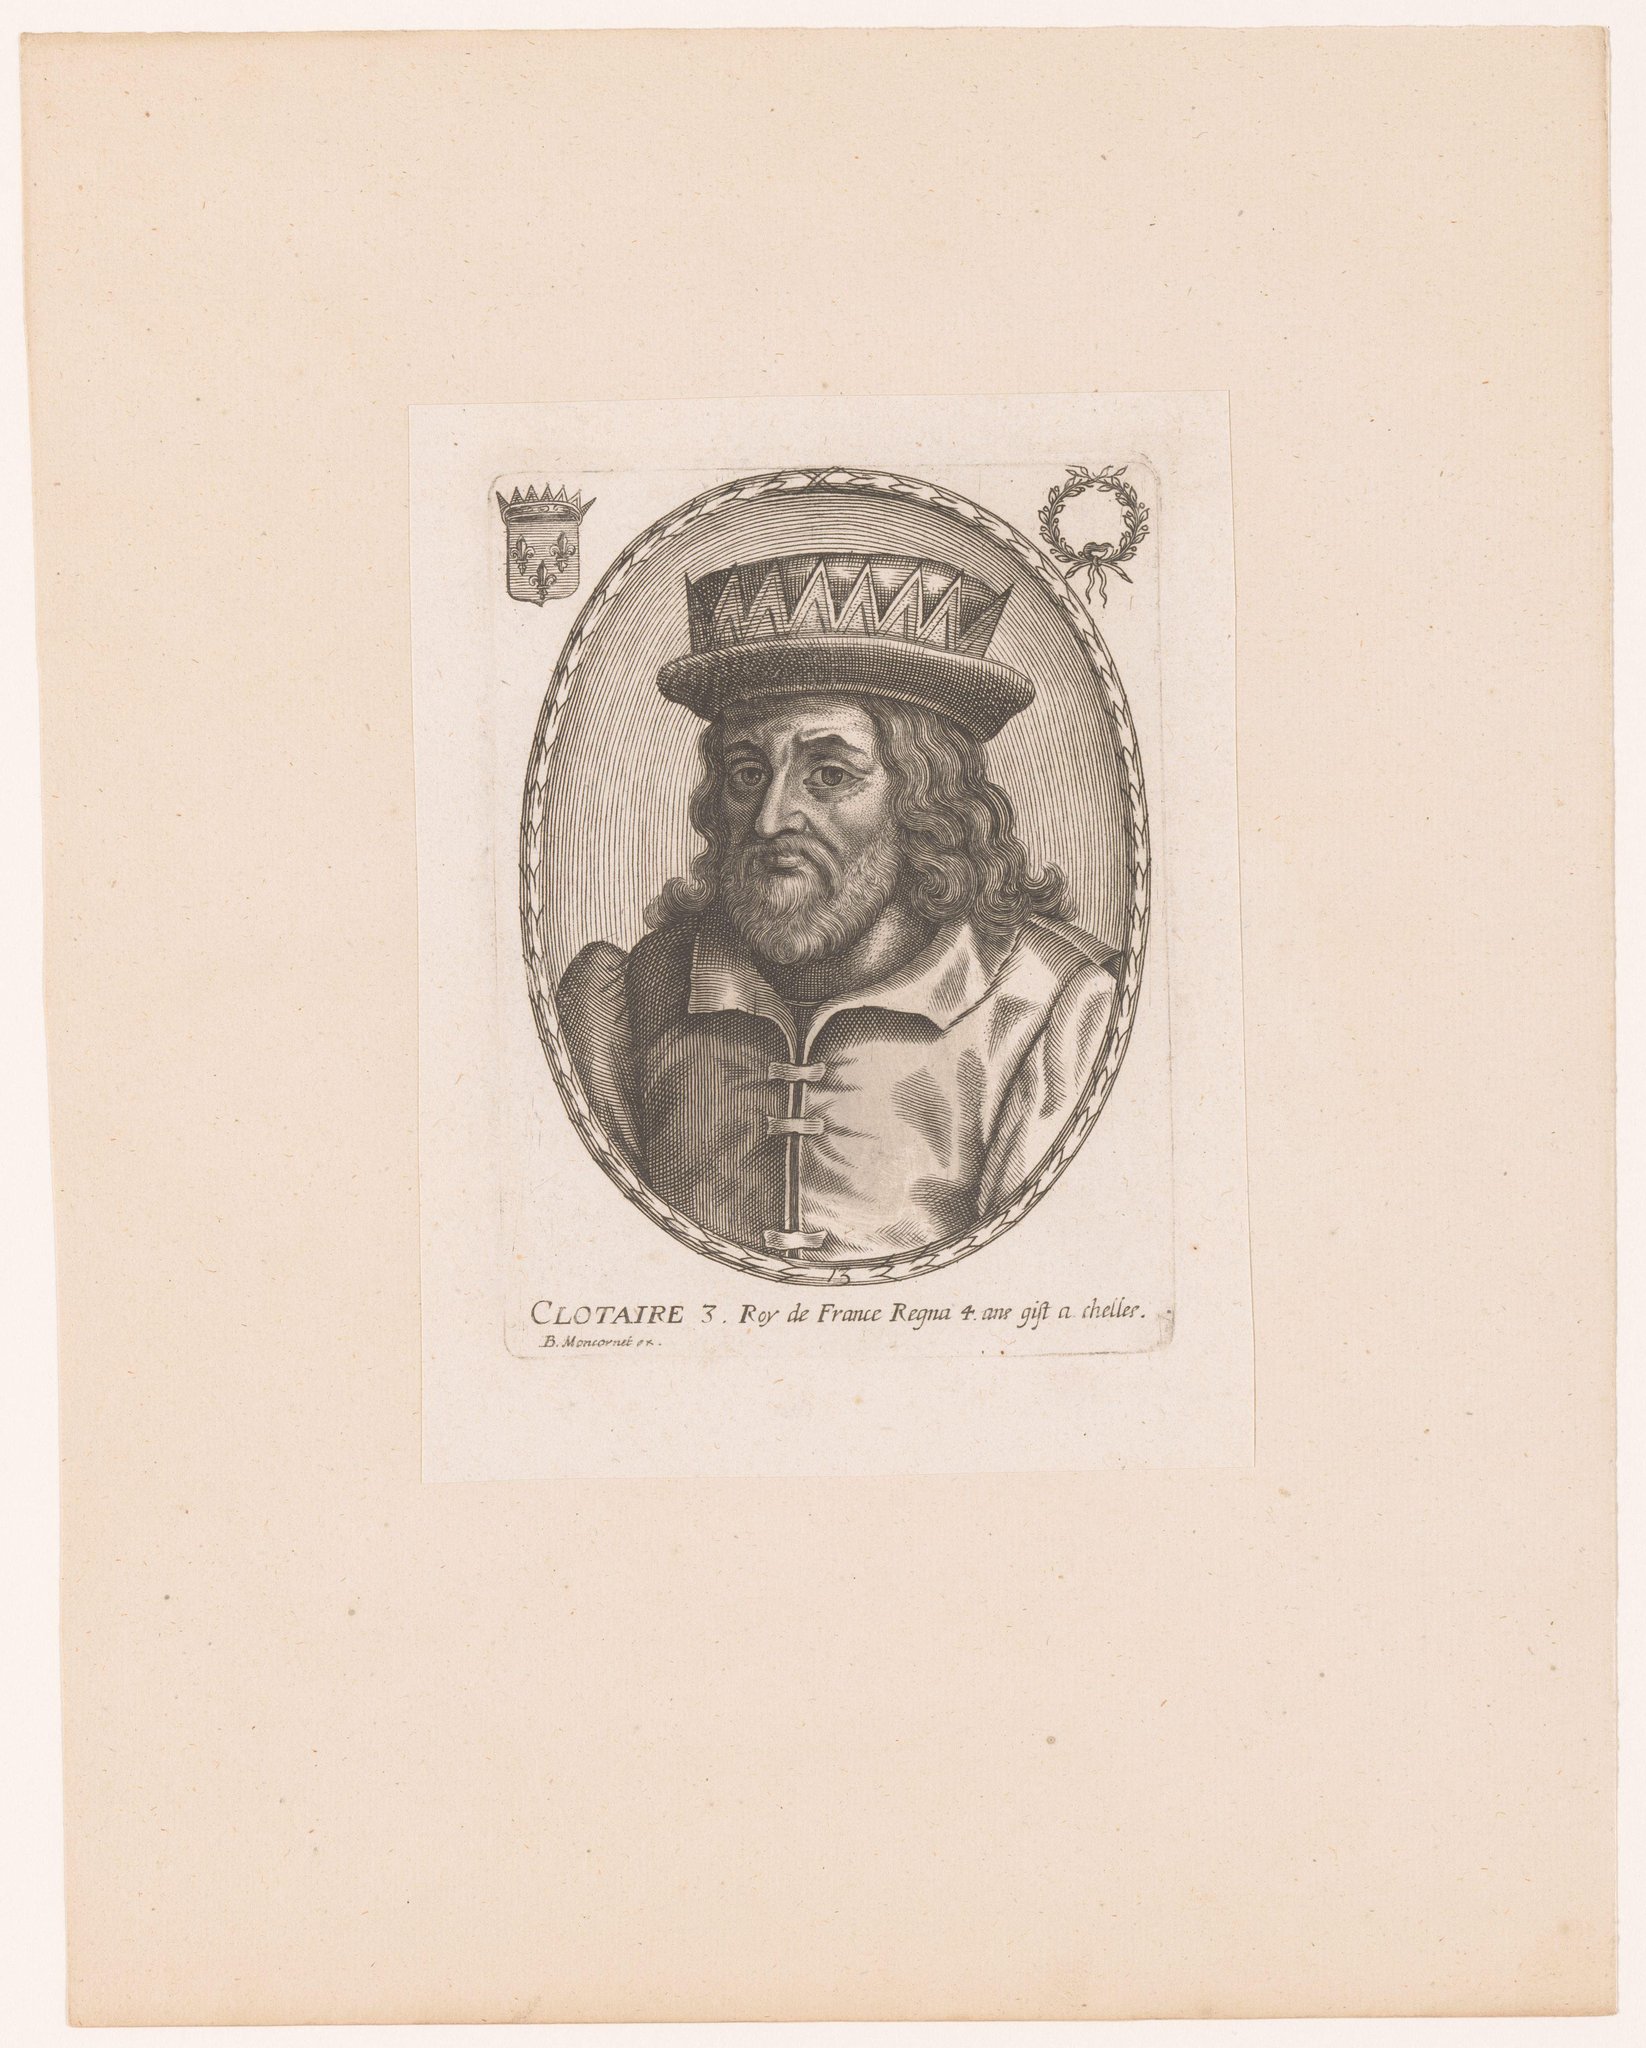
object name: print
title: Portret van Chlotarius III, koning van Frankrijk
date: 1610-1668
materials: paper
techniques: engraving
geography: paris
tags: historical persons, king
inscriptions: collector's mark: Lugt 2228